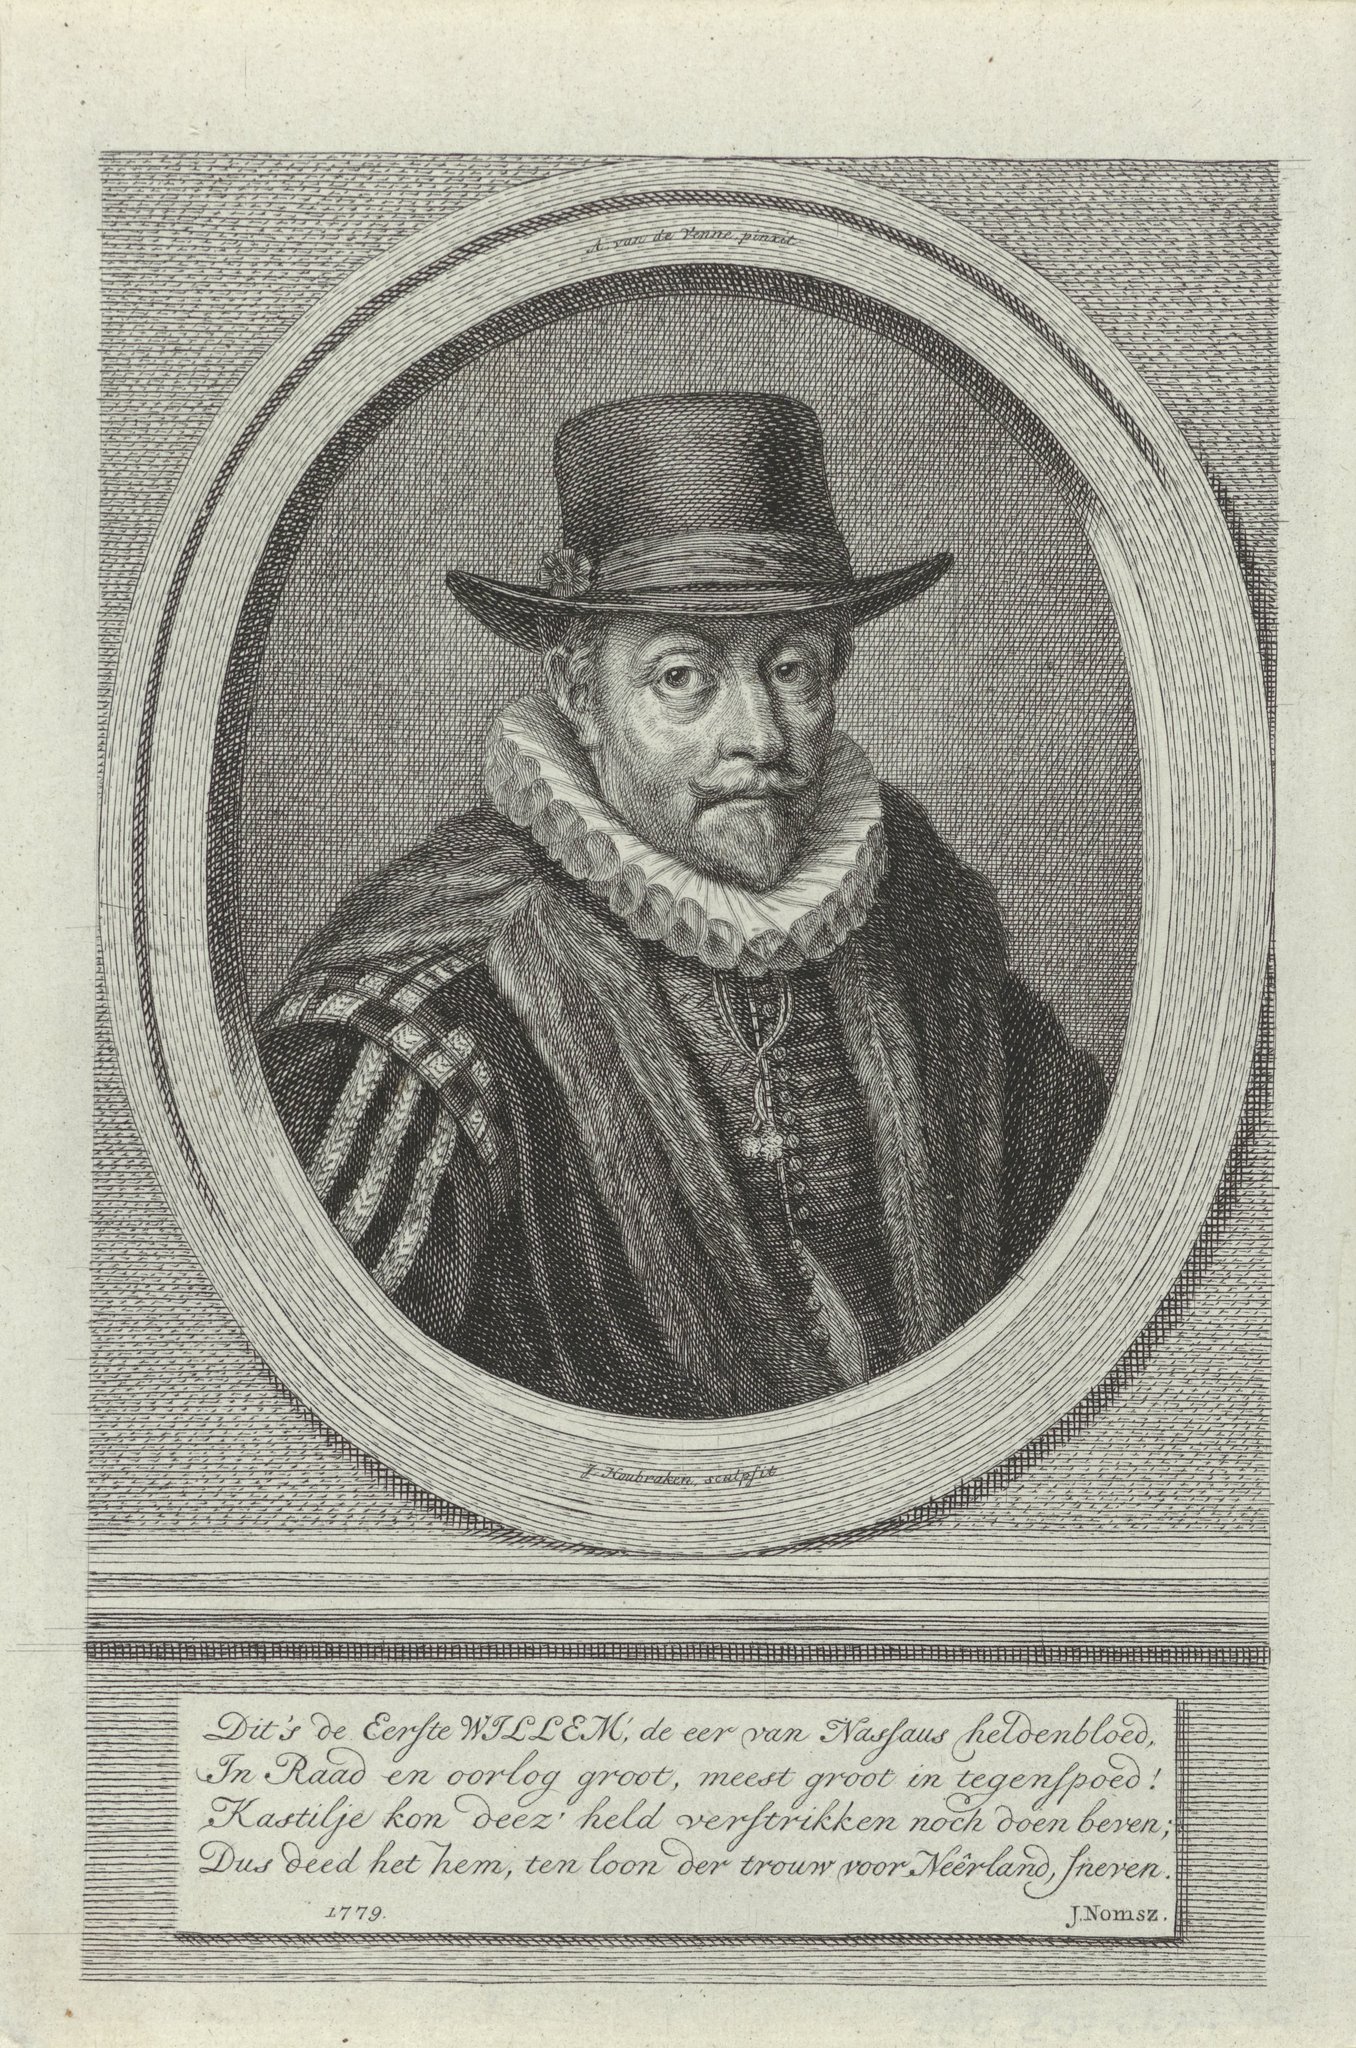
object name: print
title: Portret van Willem I, prins van Oranje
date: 1779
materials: paper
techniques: engraving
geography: amsterdam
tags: delft, william i (prince of orange)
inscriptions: date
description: De hier vermelde titel verwijst naar de hoogst verkregen titel van de geportretteerde, niet per se naar de titel die de geportretteerde op deze voorstelling draagt.